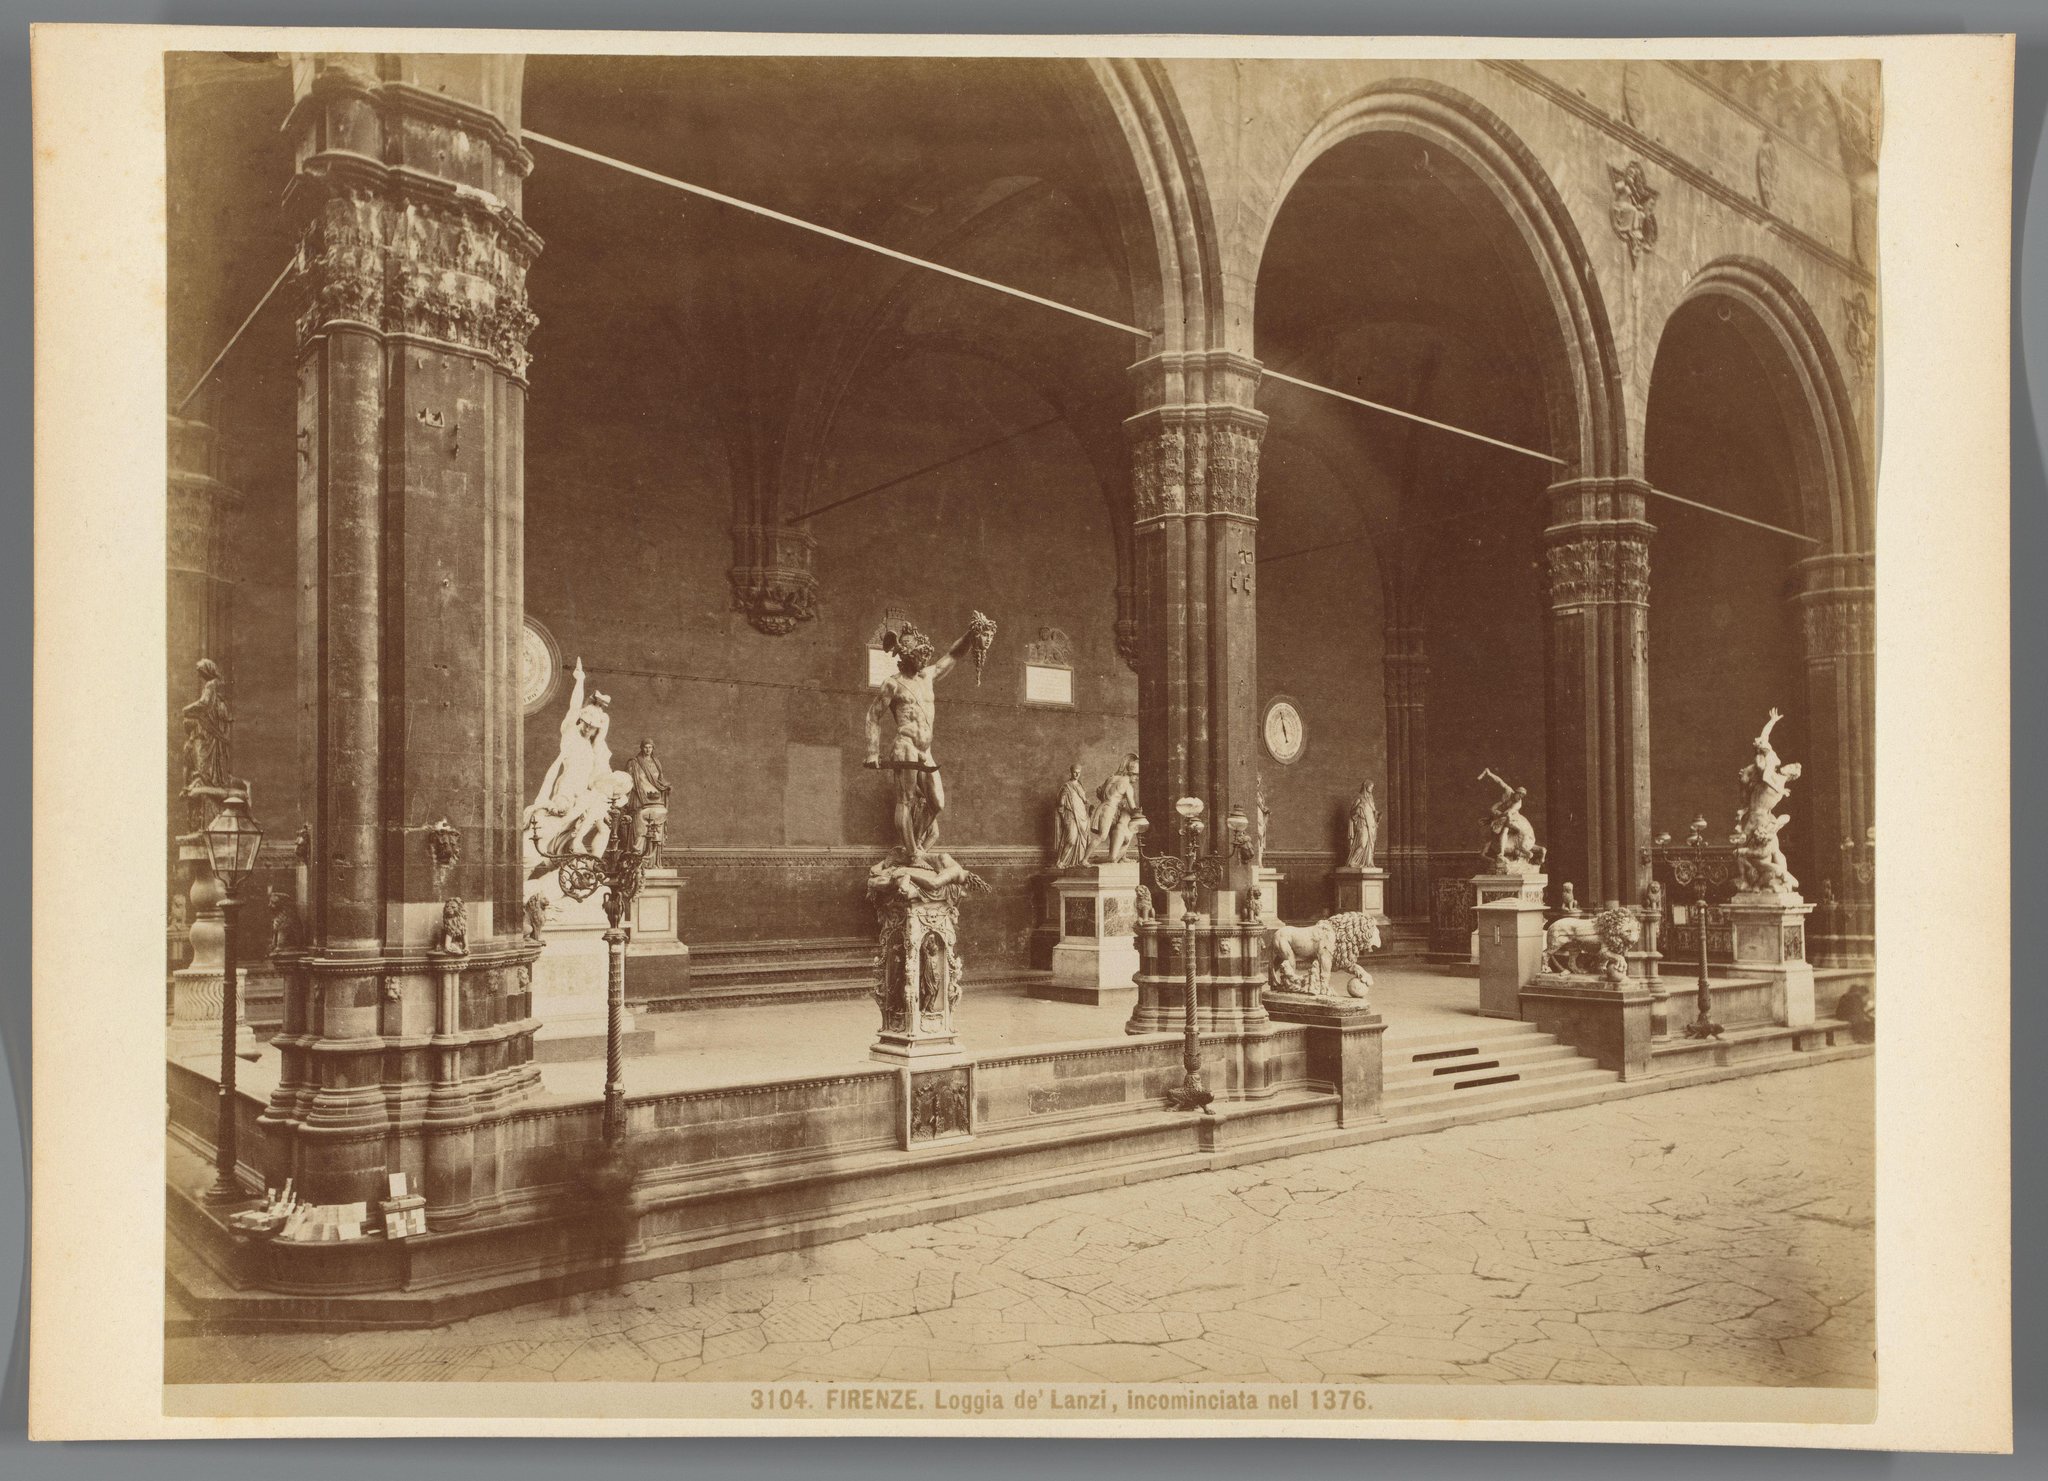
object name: photograph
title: Italië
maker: Anonymous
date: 1880-1910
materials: photographic support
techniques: albumen print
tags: italy